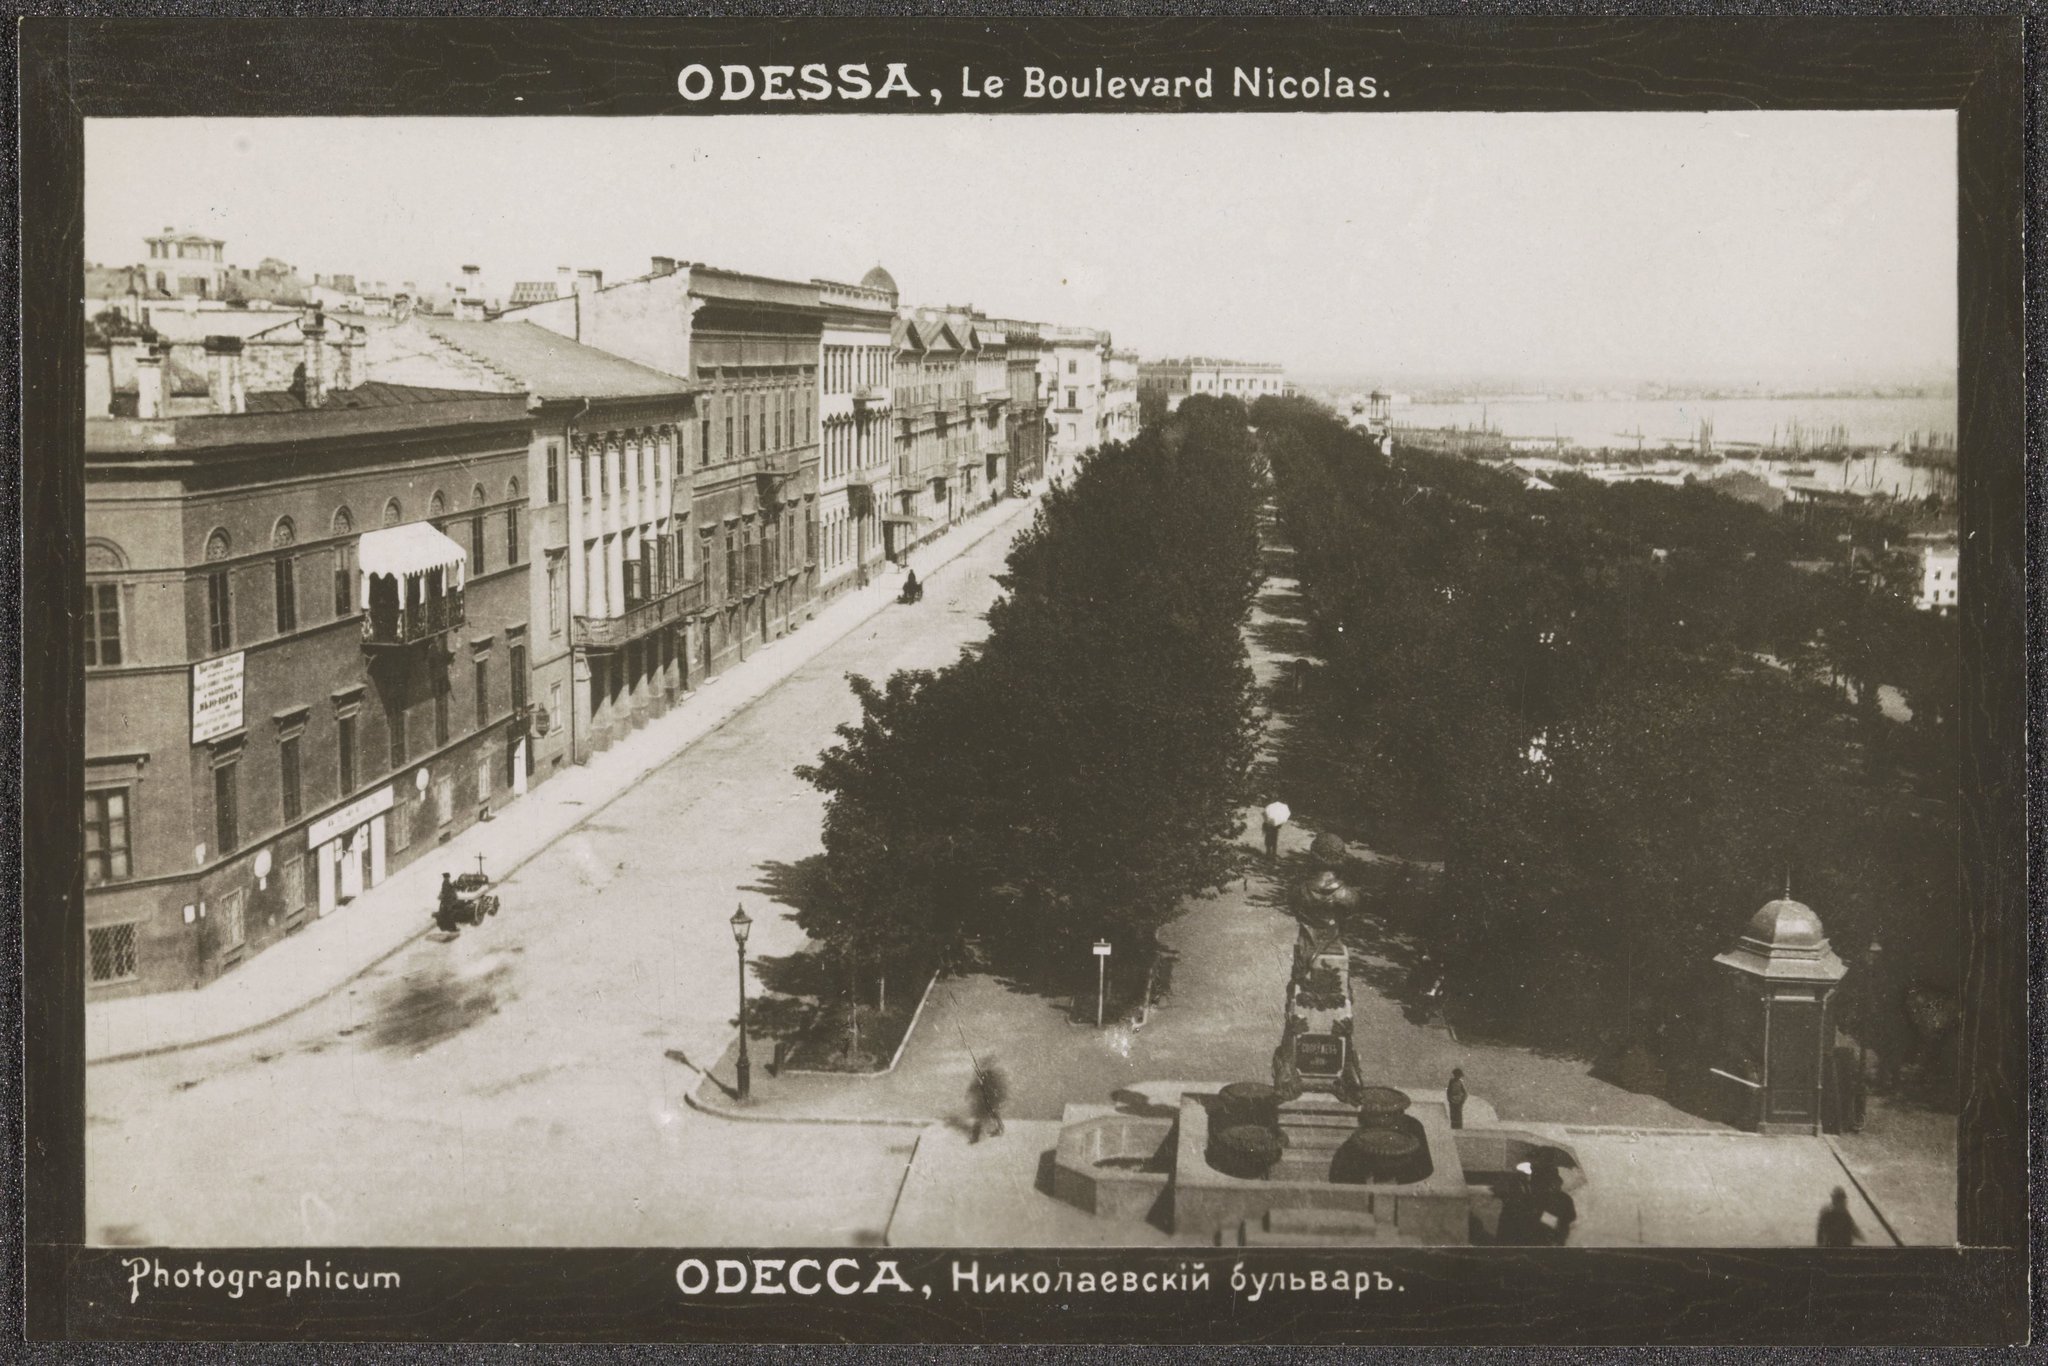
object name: photograph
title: Odessa. Le Boulevard Nicolas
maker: Anonymous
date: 1900-1930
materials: photographic support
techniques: gelatin silver print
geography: odessa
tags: avenue, boulevard, promenade, esplanade (+ city(-scape) with figures, staffage)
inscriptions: inscription: ‘Photographicum’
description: Onderdeel van Fotoalbum met opnames van bezienswaardigheden in Odessa.